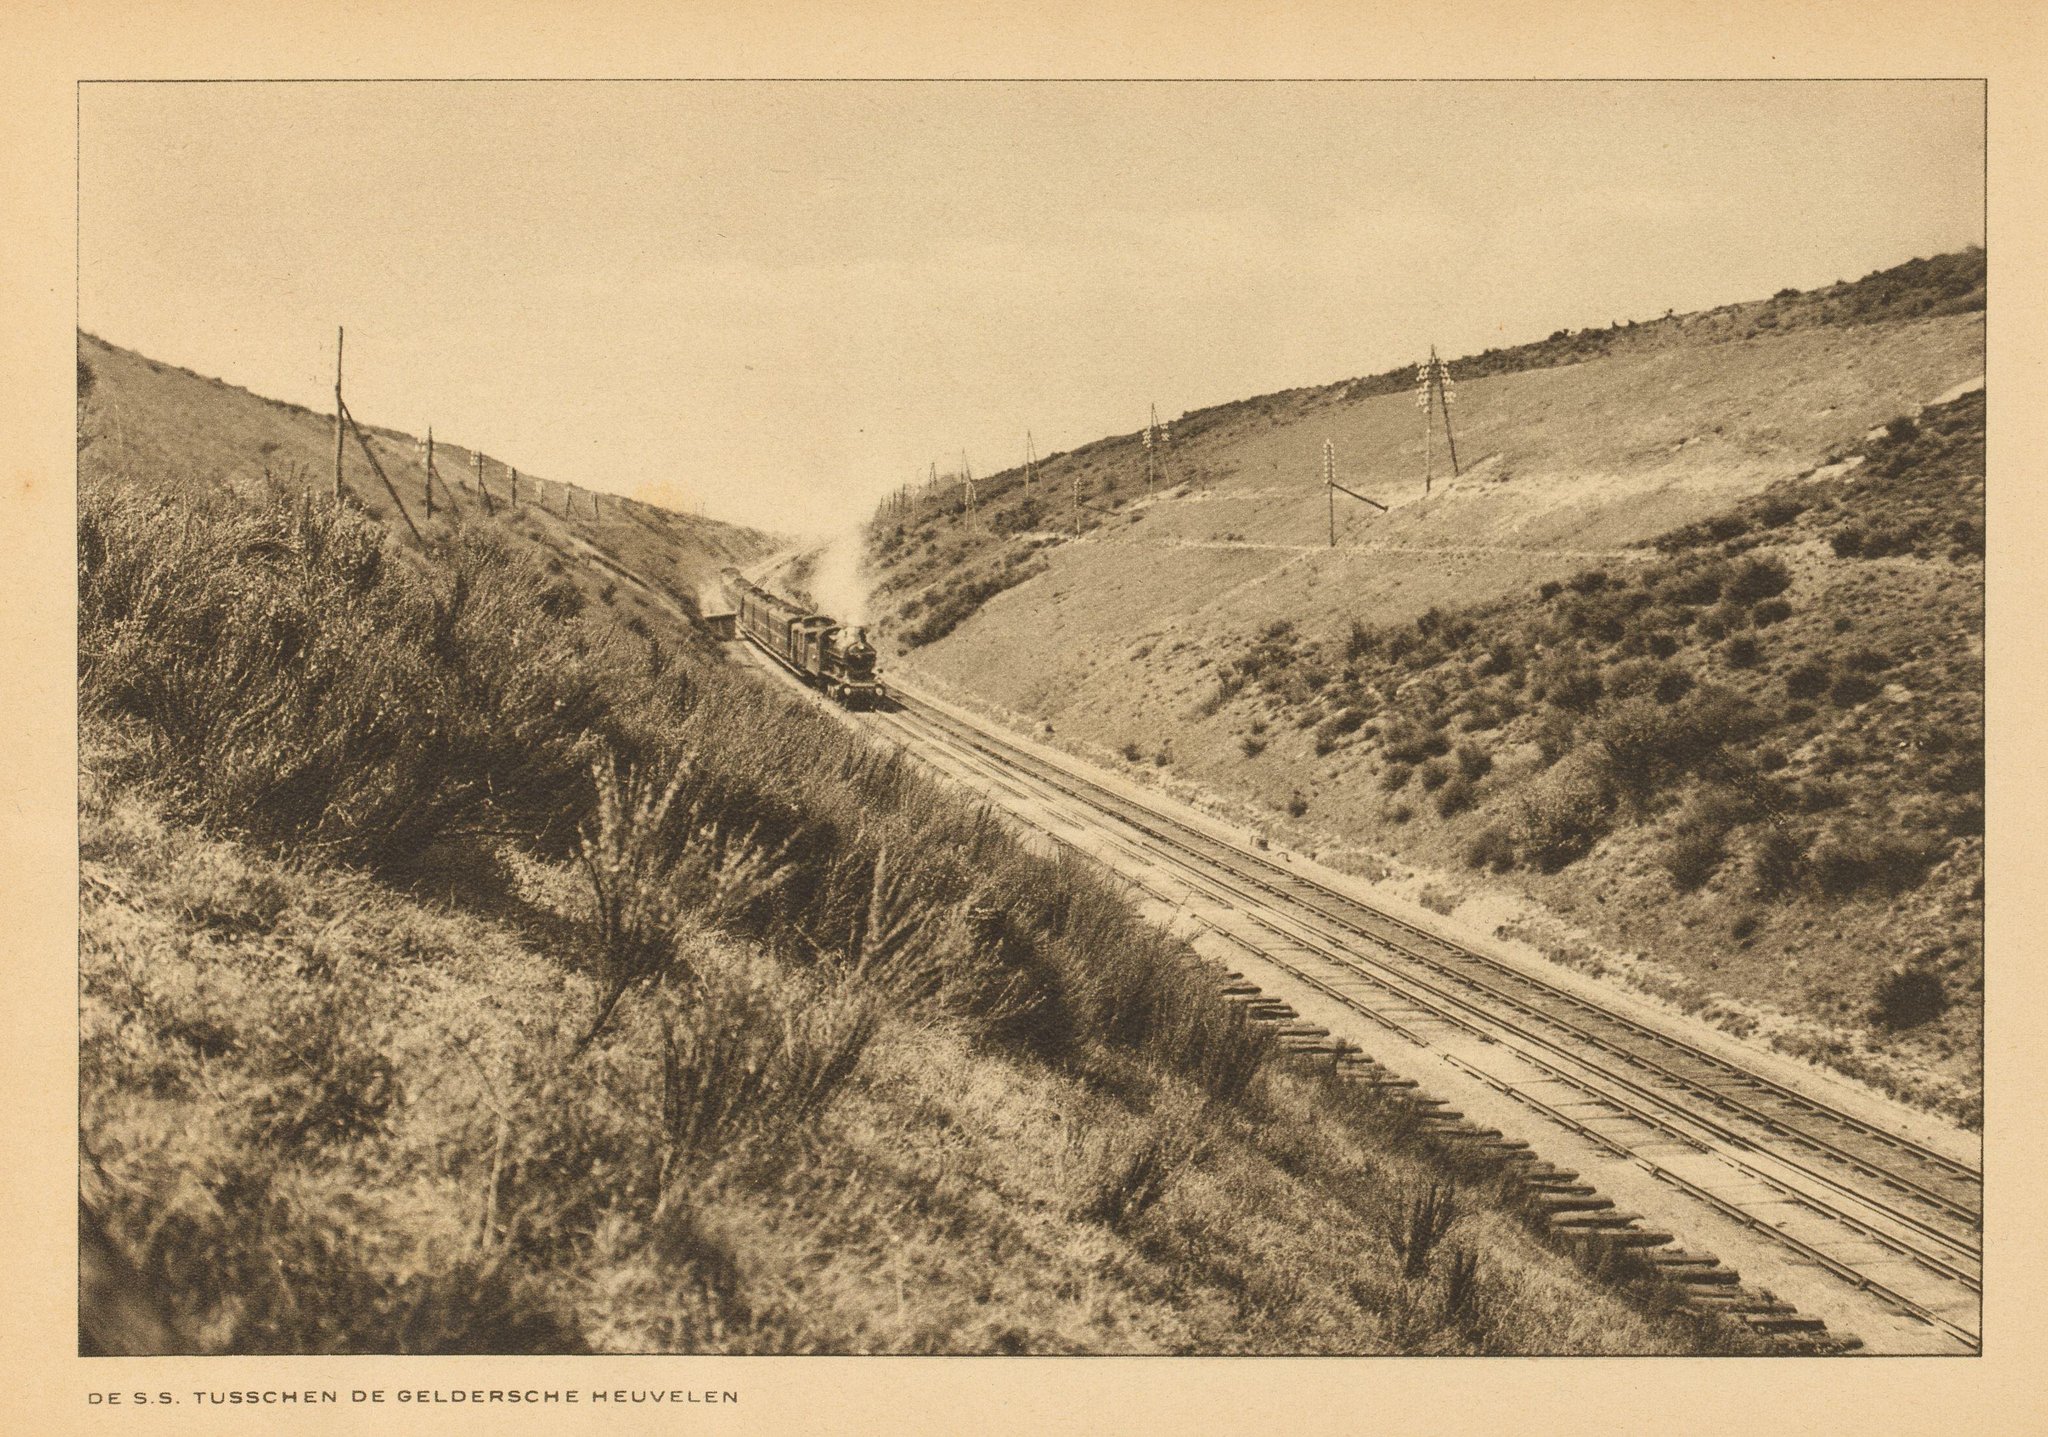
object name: album leaf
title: De s.s. tusschen de Geldersche heuvelen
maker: Anonymous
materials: paper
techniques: rotogravure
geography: leiden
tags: low hill country, railway, train, gelderland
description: Deze prent maakt deel uit van een album.